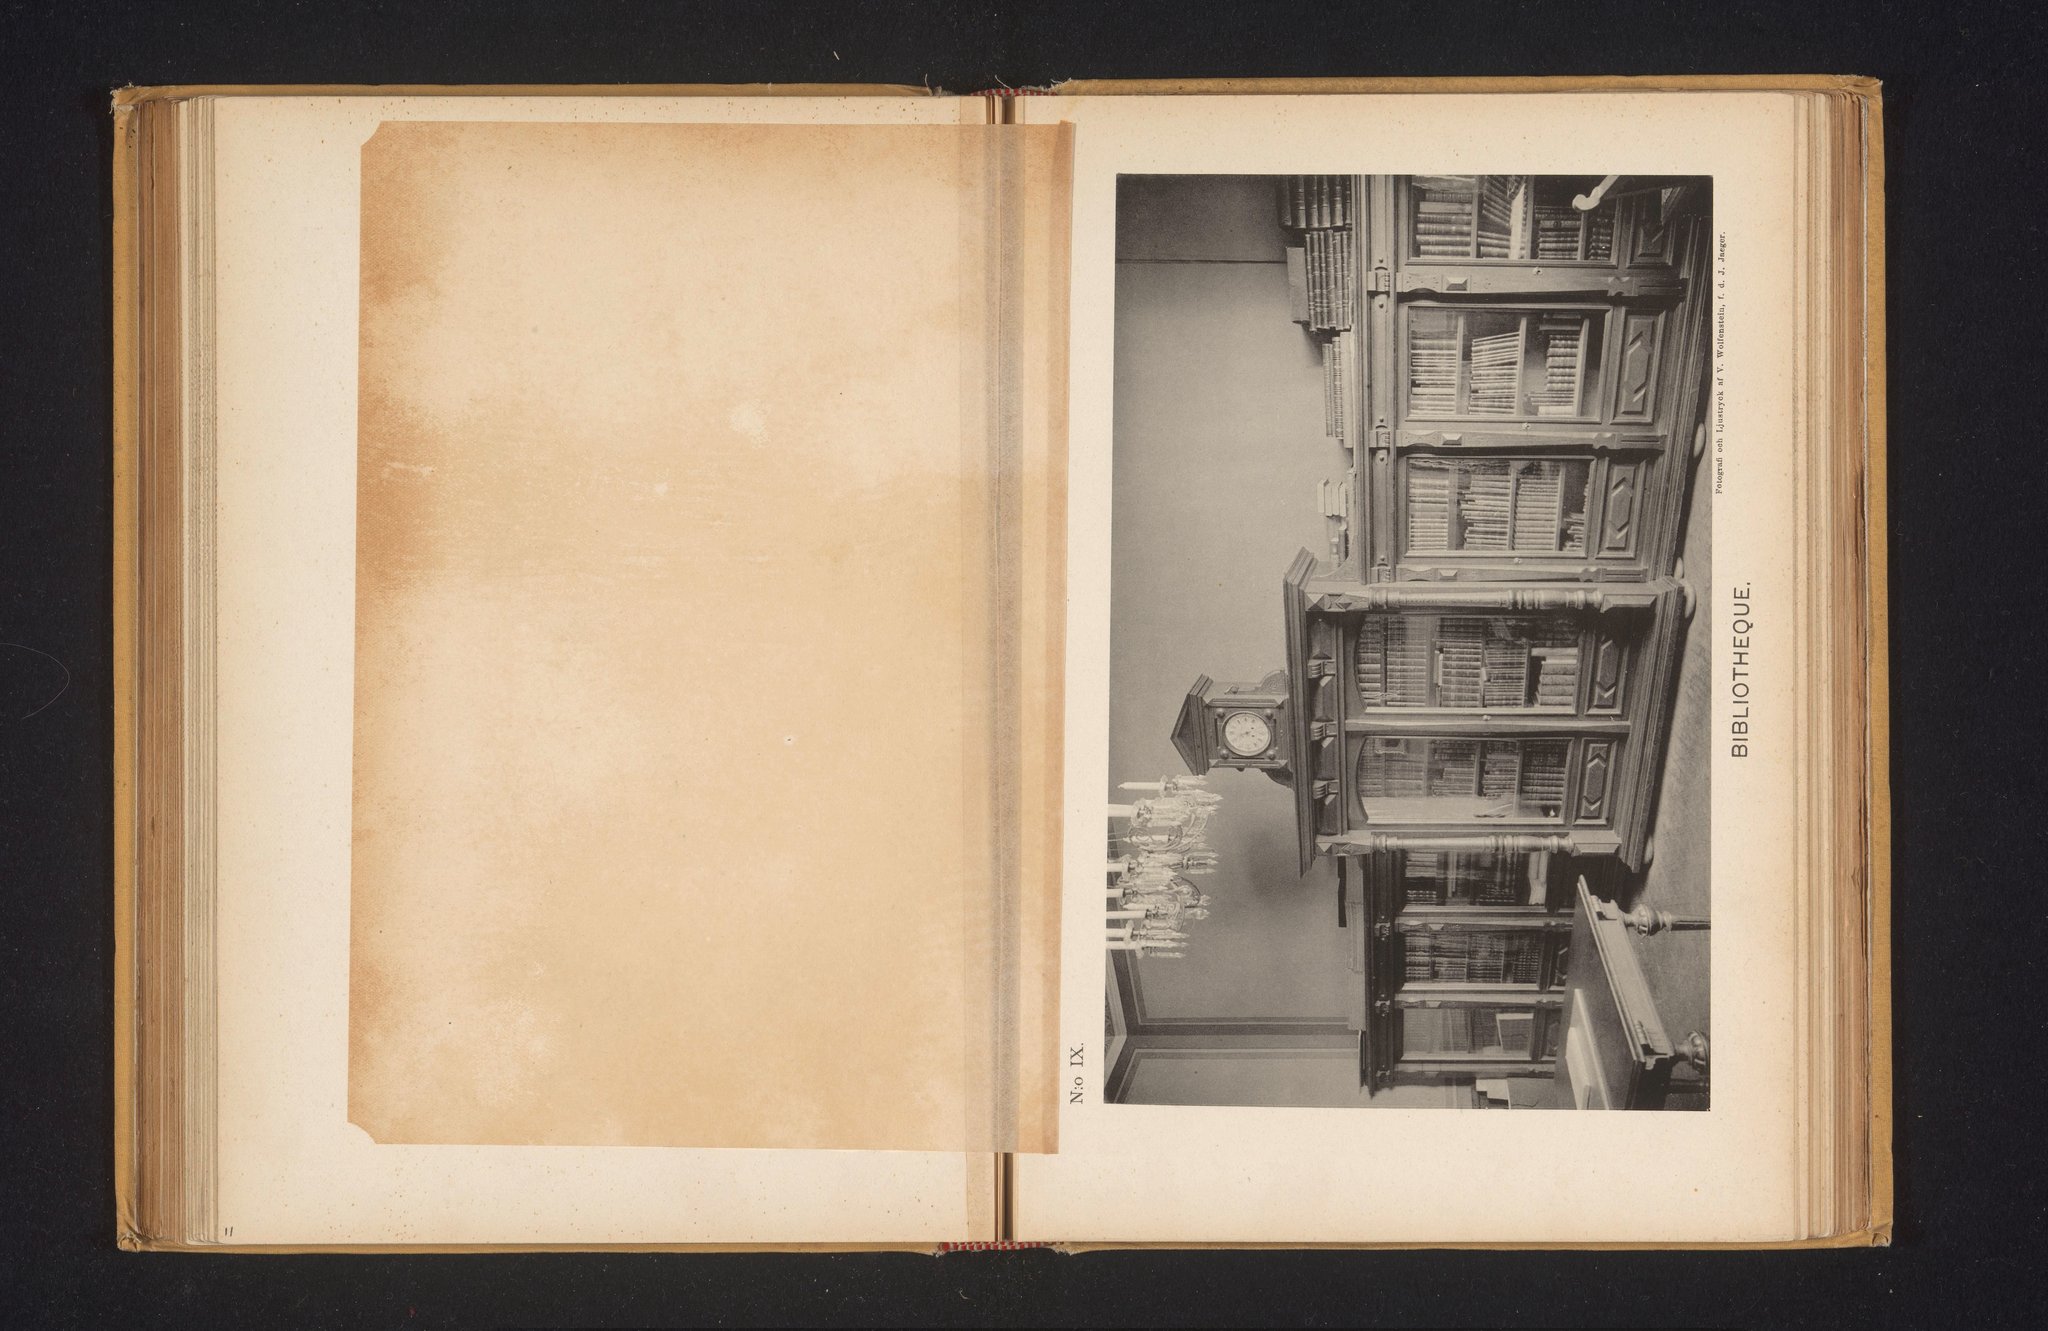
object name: page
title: Bibliotheque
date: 1888-1891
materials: paper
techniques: photograph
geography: stockholm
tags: study; 'studiolo'; library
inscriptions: number: ‘N:o IX.’